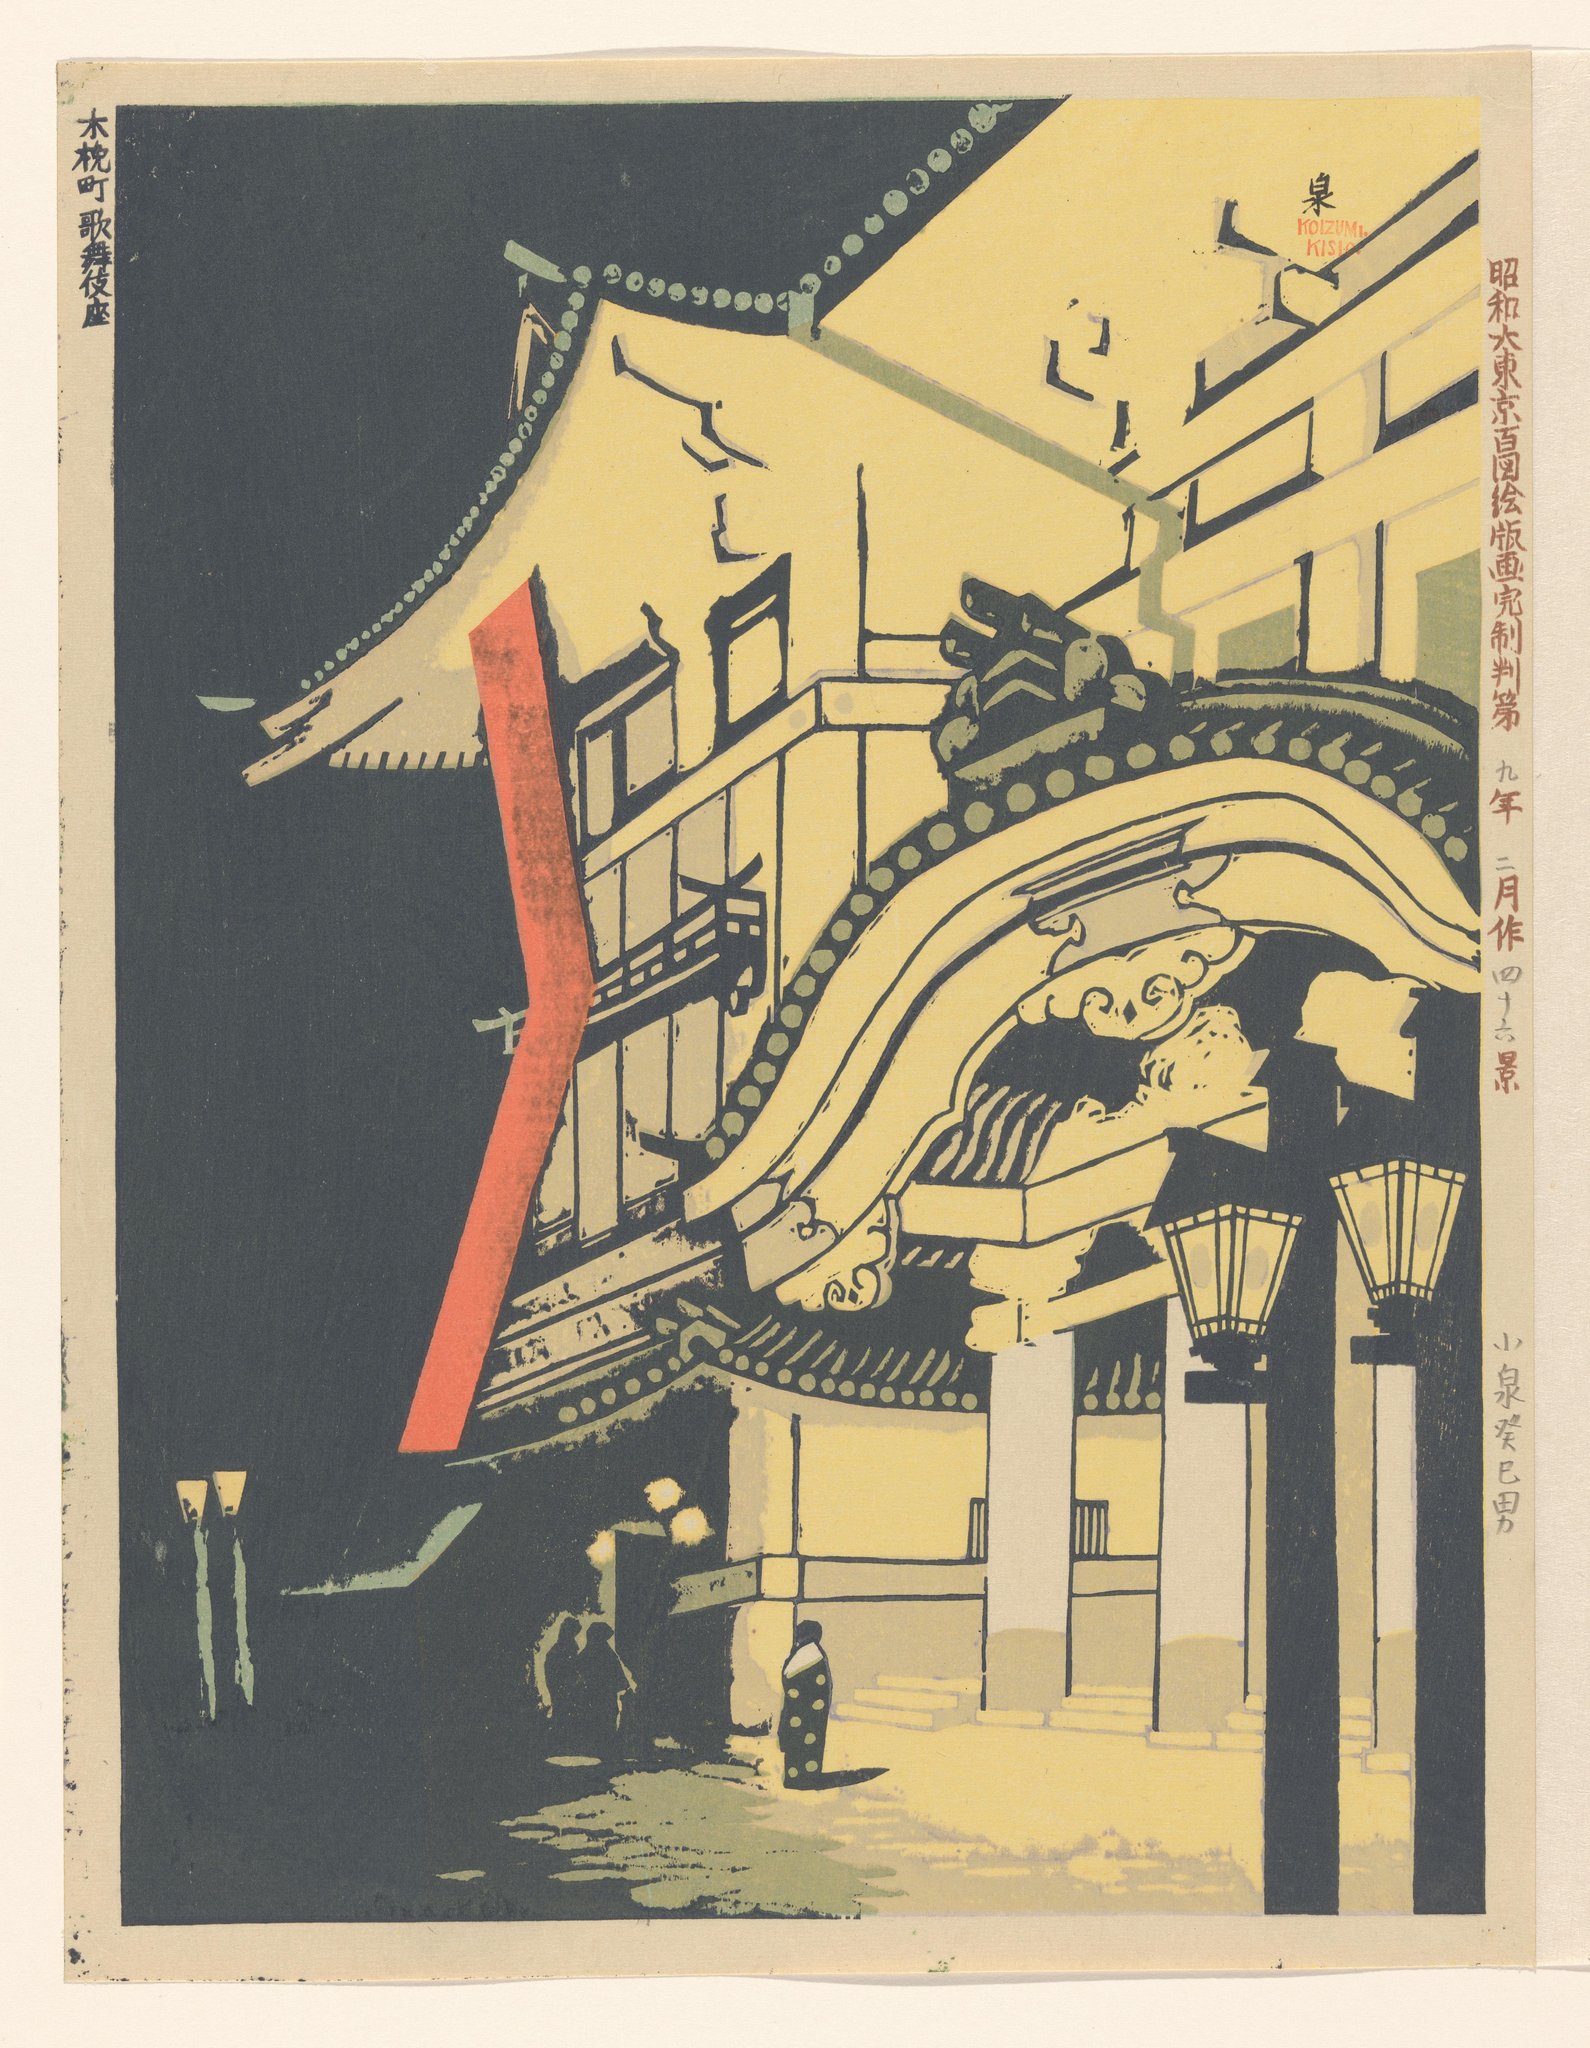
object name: print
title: Kobikichō Kabukiza yonjūrokkei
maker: koizumi kishio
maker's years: 1893-1945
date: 1902-1934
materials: paper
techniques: woodcut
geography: japan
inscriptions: seal: ‘Koizumi Kisio.’, signature: ‘Izumi’, signature: ‘小泉癸巳男’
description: De verlichte gevel van het Kabuki-theater steekt op tegen de duistere achtergrond. In september 1928 begon Koizumi Kishio aan zijn ambitieuze plan om honderd landschapsprenten met scènes in Tokyo volledig zelf te ontwerpen, hiervan zelf de drukblokken te snijden en zelf de prenten te drukken. De aanleiding voor het project was grote verandering die Tokyo onderging door de verwoestende Grote Kantō-aardbeving van 1923 en de wederopbouw die daarop volgde. Kishio maakt een bewuste verwijzing naar de bekende serie ‘Honderd beroemde gezichten op Edo’ door Utagawa Hiroshige (1797–1858), met prenten van locaties in Edo—de oude benaming voor Tokyo. Kishio toont overwegend moderne gebouwen, instituten en mensen die de tijdsgeest van de jaren 1920 en 1930 weerspiegelen. Sommige prenten onthullen daarentegen een nostalgische blik op overblijfselen uit het oude Edo. Kishio verkocht de prenten aan de hand van een abonnement met een limiet van vijftig leden, die elke maand een of twee prenten zouden ontvangen. Het project begon met negen abonnementen, maar al na de tweede maand werden meerdere daarvan opgezegd en slechts vier mecenassen bleven lid tot en met de voltooiing van de serie. Hij bracht het honderdste ontwerp uit in 1937. Zijn leermeester Ishii Hakutei schreef een inleiding in 1938 die Kishio verwerkte tot een prent en toevoegde aan de set. Tussen 1939 en 1940 maakte hij nog eens negen extra ontwerpen. Met acht van deze ontwerpen verving hij oudere nummers uit de serie, mogelijk omdat hij niet tevreden was met de composities. Uiteindelijk lukte het Kishio om tien complete sets te verkopen aan de shin hanga-uitgever Watanabe Shōzaburō en liet hiervoor speciale houten dozen maken. Deze prent behoort tot een van die tien sets.